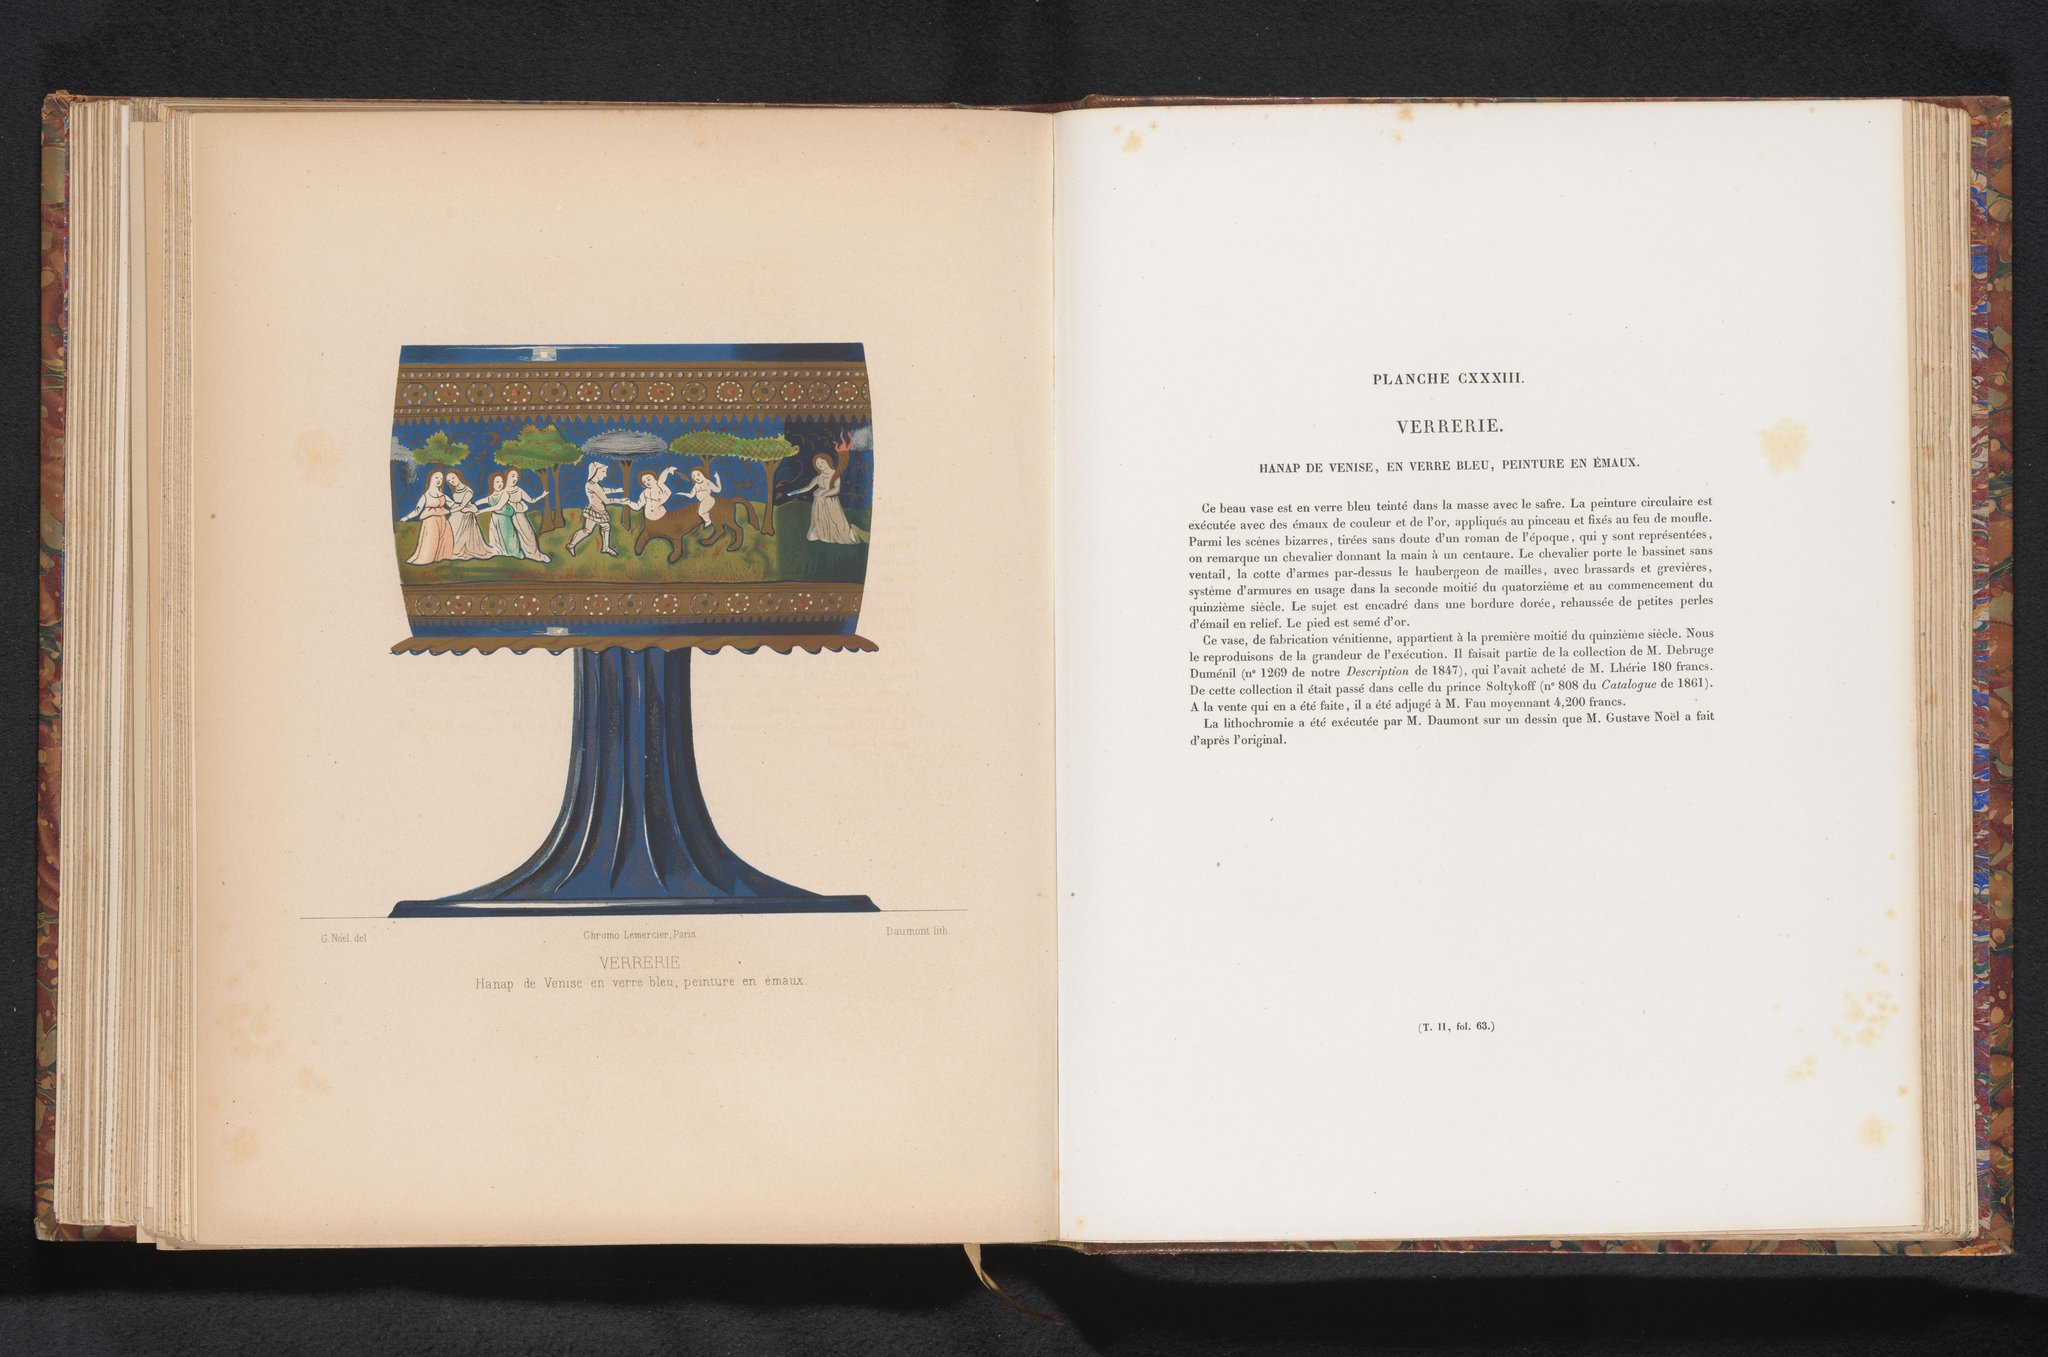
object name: print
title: Reproductie van een ontwerp van een gedecoreerde vaas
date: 1859-1864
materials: paper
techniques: chromolithography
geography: paris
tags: container of glass: bottle, jar, vase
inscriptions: name: ‘G. Noël. del./ Daumont lith.’